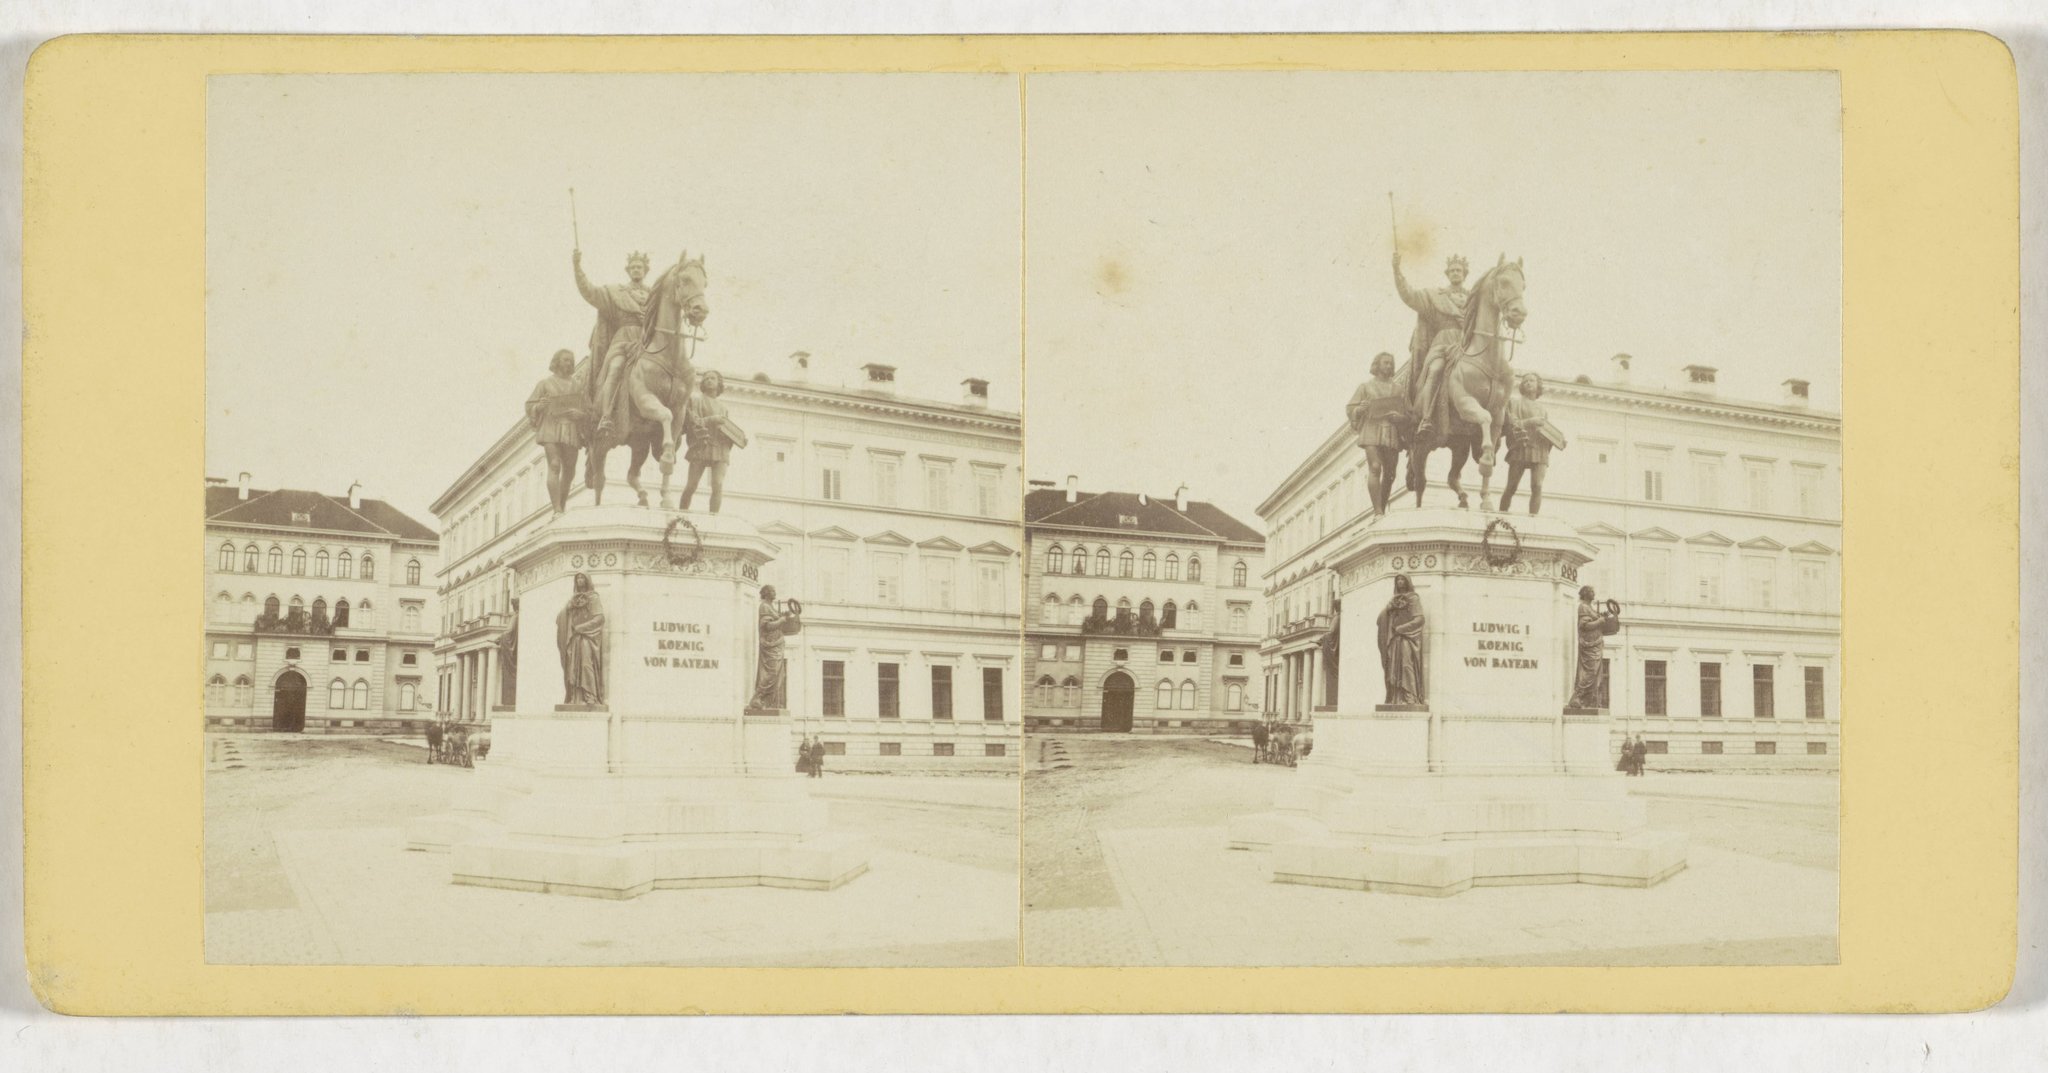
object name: stereograph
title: Deutschland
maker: johann friedrich stiehm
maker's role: fotograaf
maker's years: 1826-1902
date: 1868-1890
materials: cardboard, paper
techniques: albumen print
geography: munich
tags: lodewijk i (koning van beieren), equestrian statue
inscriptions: number: ‘No. 4.’